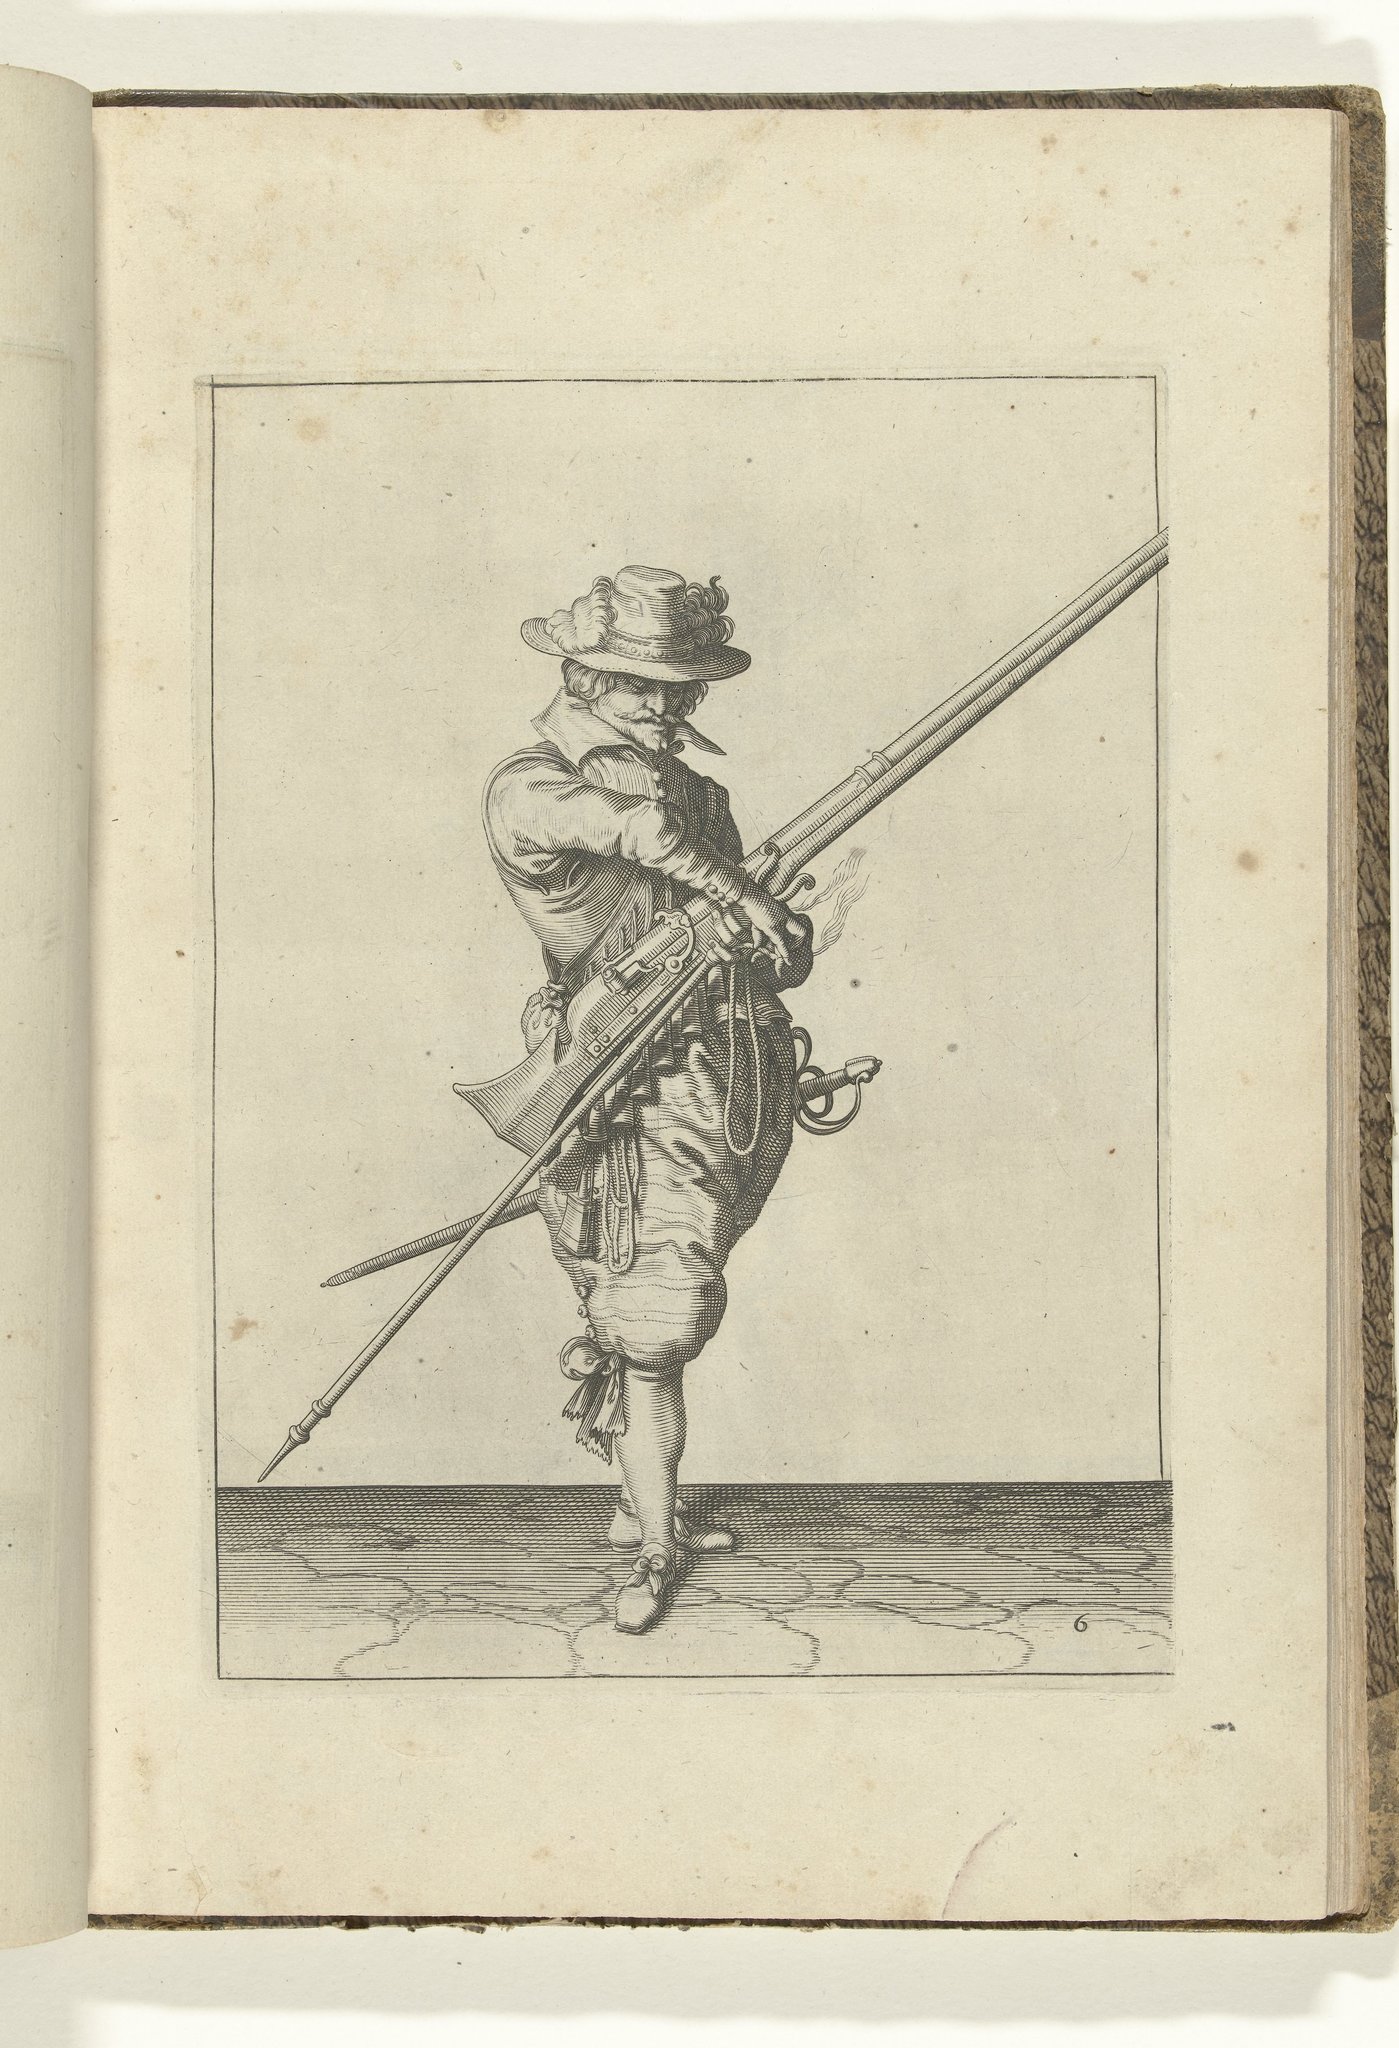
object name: print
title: Soldaat met een musket die zijn lont pakt (nr. 6), ca. 1600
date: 1597-1608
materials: paper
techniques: engraving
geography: northern netherlands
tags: maurice (prince of orange), handling of weapons ~ military training, weapons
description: Een soldaat, ten voeten uit, naar rechts, die een musket (een bepaald type vuurwapen) met zijn linkerhand vasthoudt (nr. 6), ca. 1600. In zijn linkerhand behalve het musket ook een furket (musketvork) en een brandende lont. Met zijn rechterhand pakt hij deze lont. Plaat 6 in de instructies voor het hanteren van het musket: Brief enseignement, sur les pourtraitz figurez, touchant le droit maniement du Mousquet. Onderdeel van de illustraties in een Franse editie van J. de Gheyns Wapenhandelinghe: J. de Gheyn, Maniement d'armes, d'arquebuses, mousquetz et piques : en conformité de l'ordre de Mour le Prince Maurice, Prince d'Orange, Amsterdam 1608. Krijgswezen rond 1600.